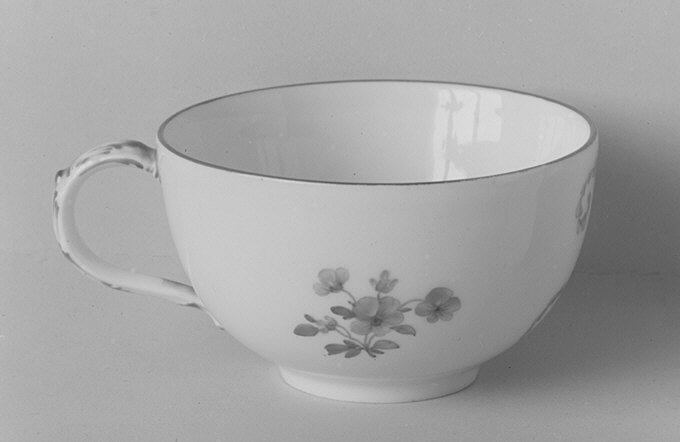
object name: cup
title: Cup (part of a set)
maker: royal porcelain manufactory, berlin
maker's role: manufactory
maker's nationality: german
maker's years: 1763-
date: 1765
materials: hard paste porcelain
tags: flowers